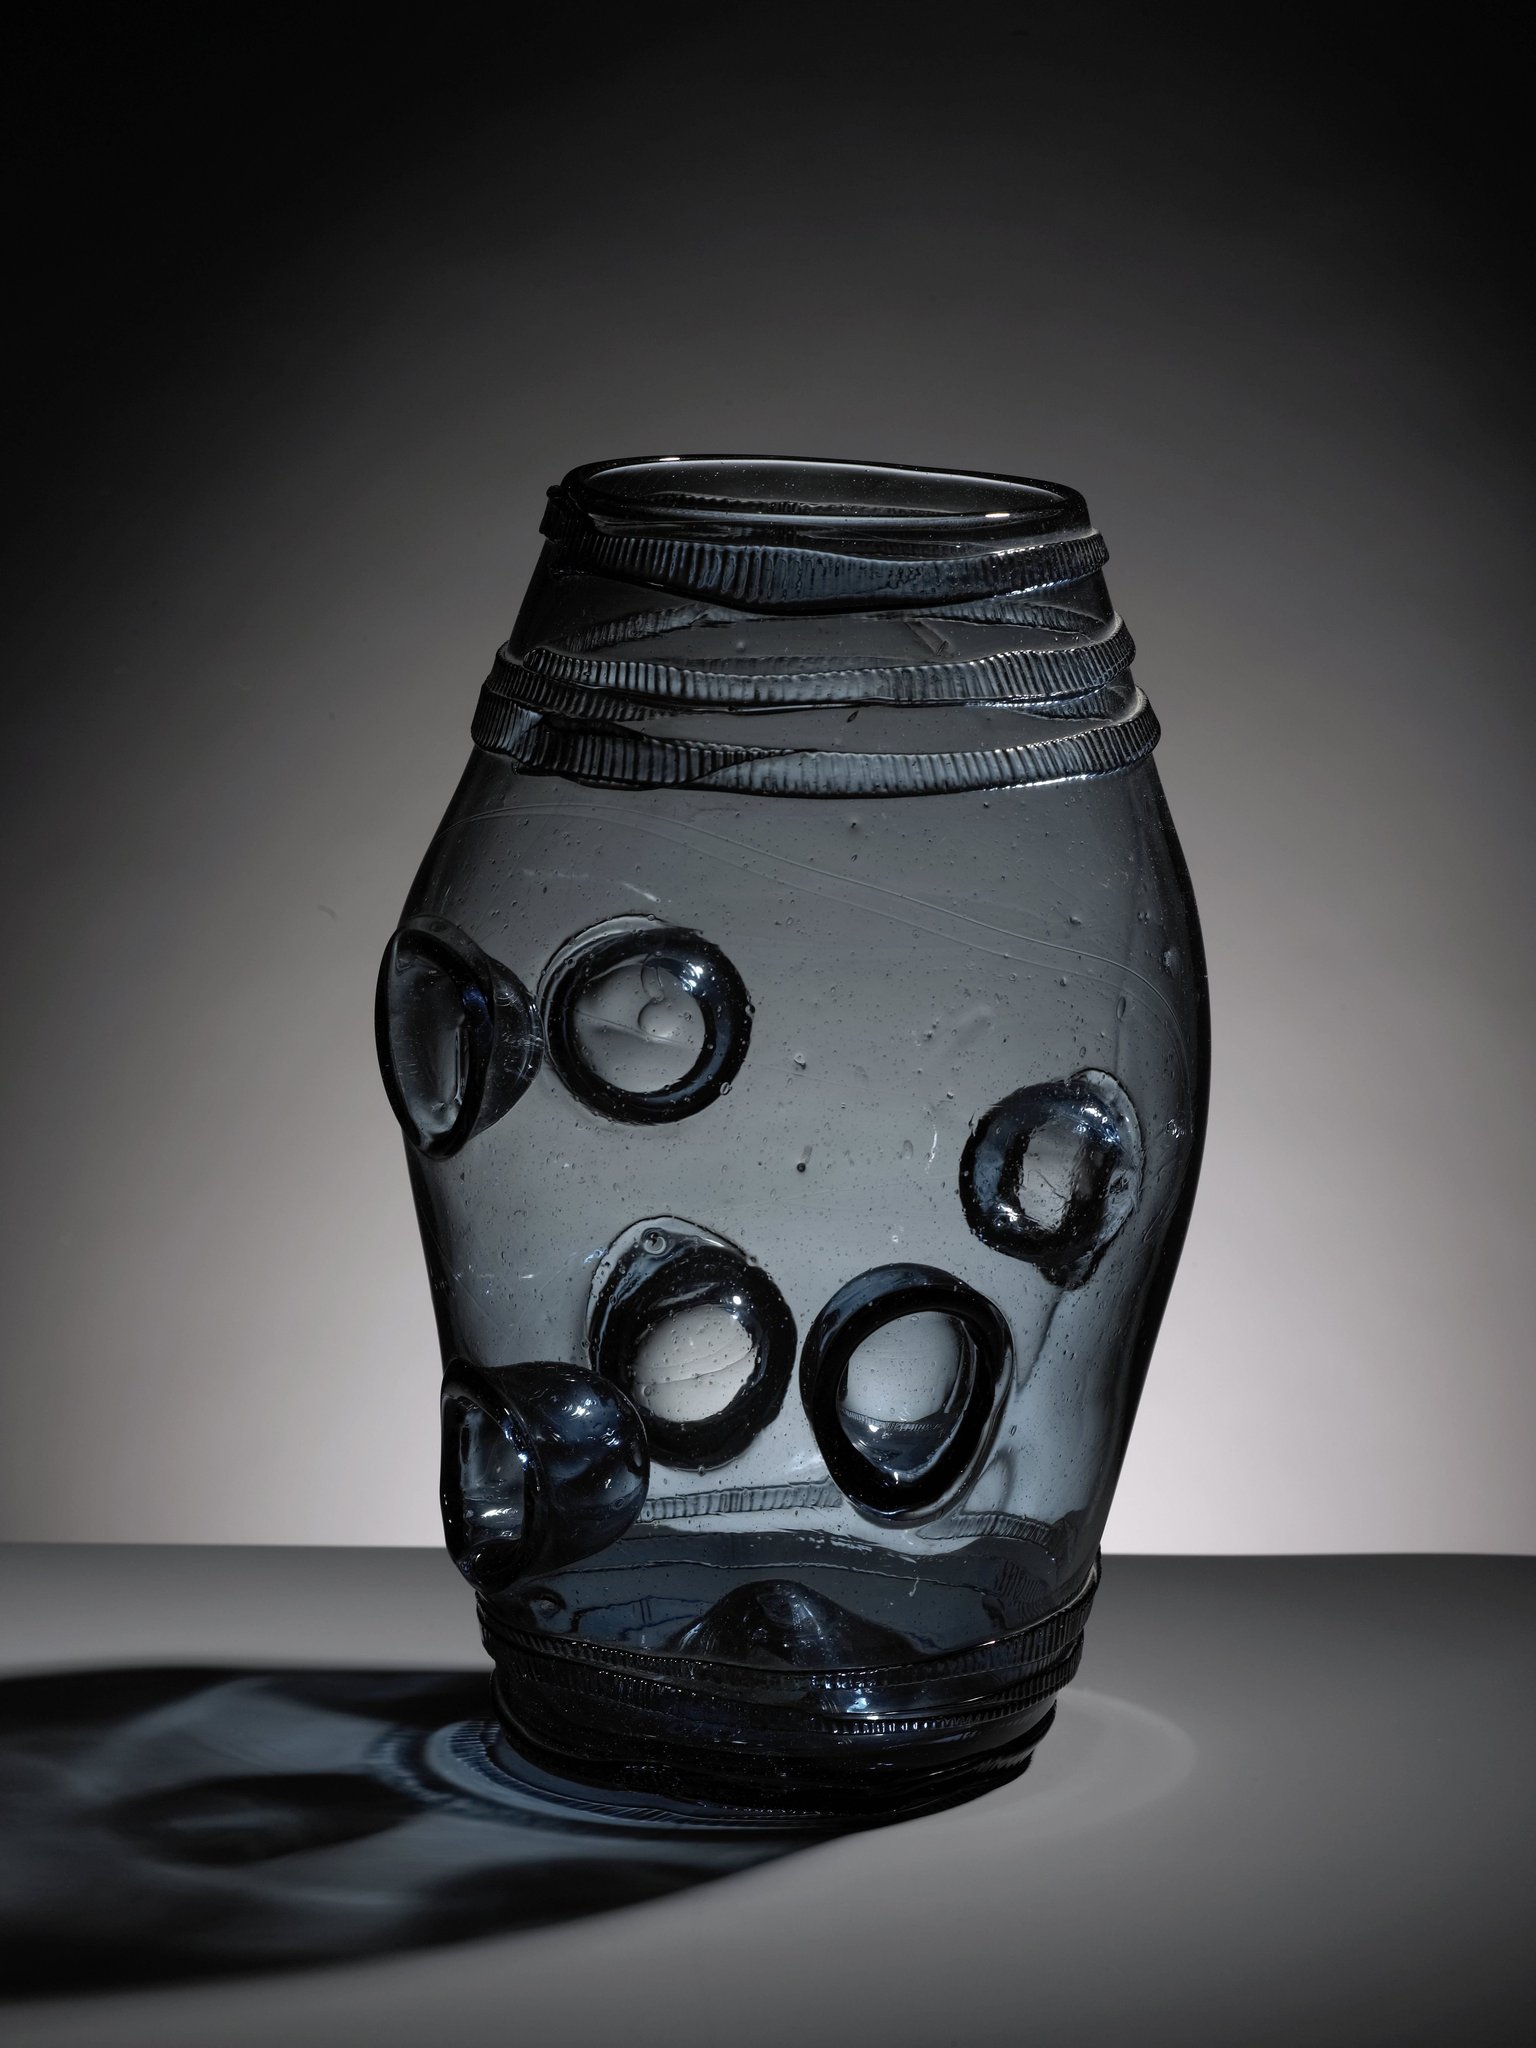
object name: duimenglas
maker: Anonymous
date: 1600-1700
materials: glass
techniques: glassblowing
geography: germany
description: Duimenglas van blauw glas met gewelfde bodem. Lichaam tonvormig met langs onder- en bovenkant drie geknepen geribde draden. Tot driekwart hoogte voorzien van zes duimgaten